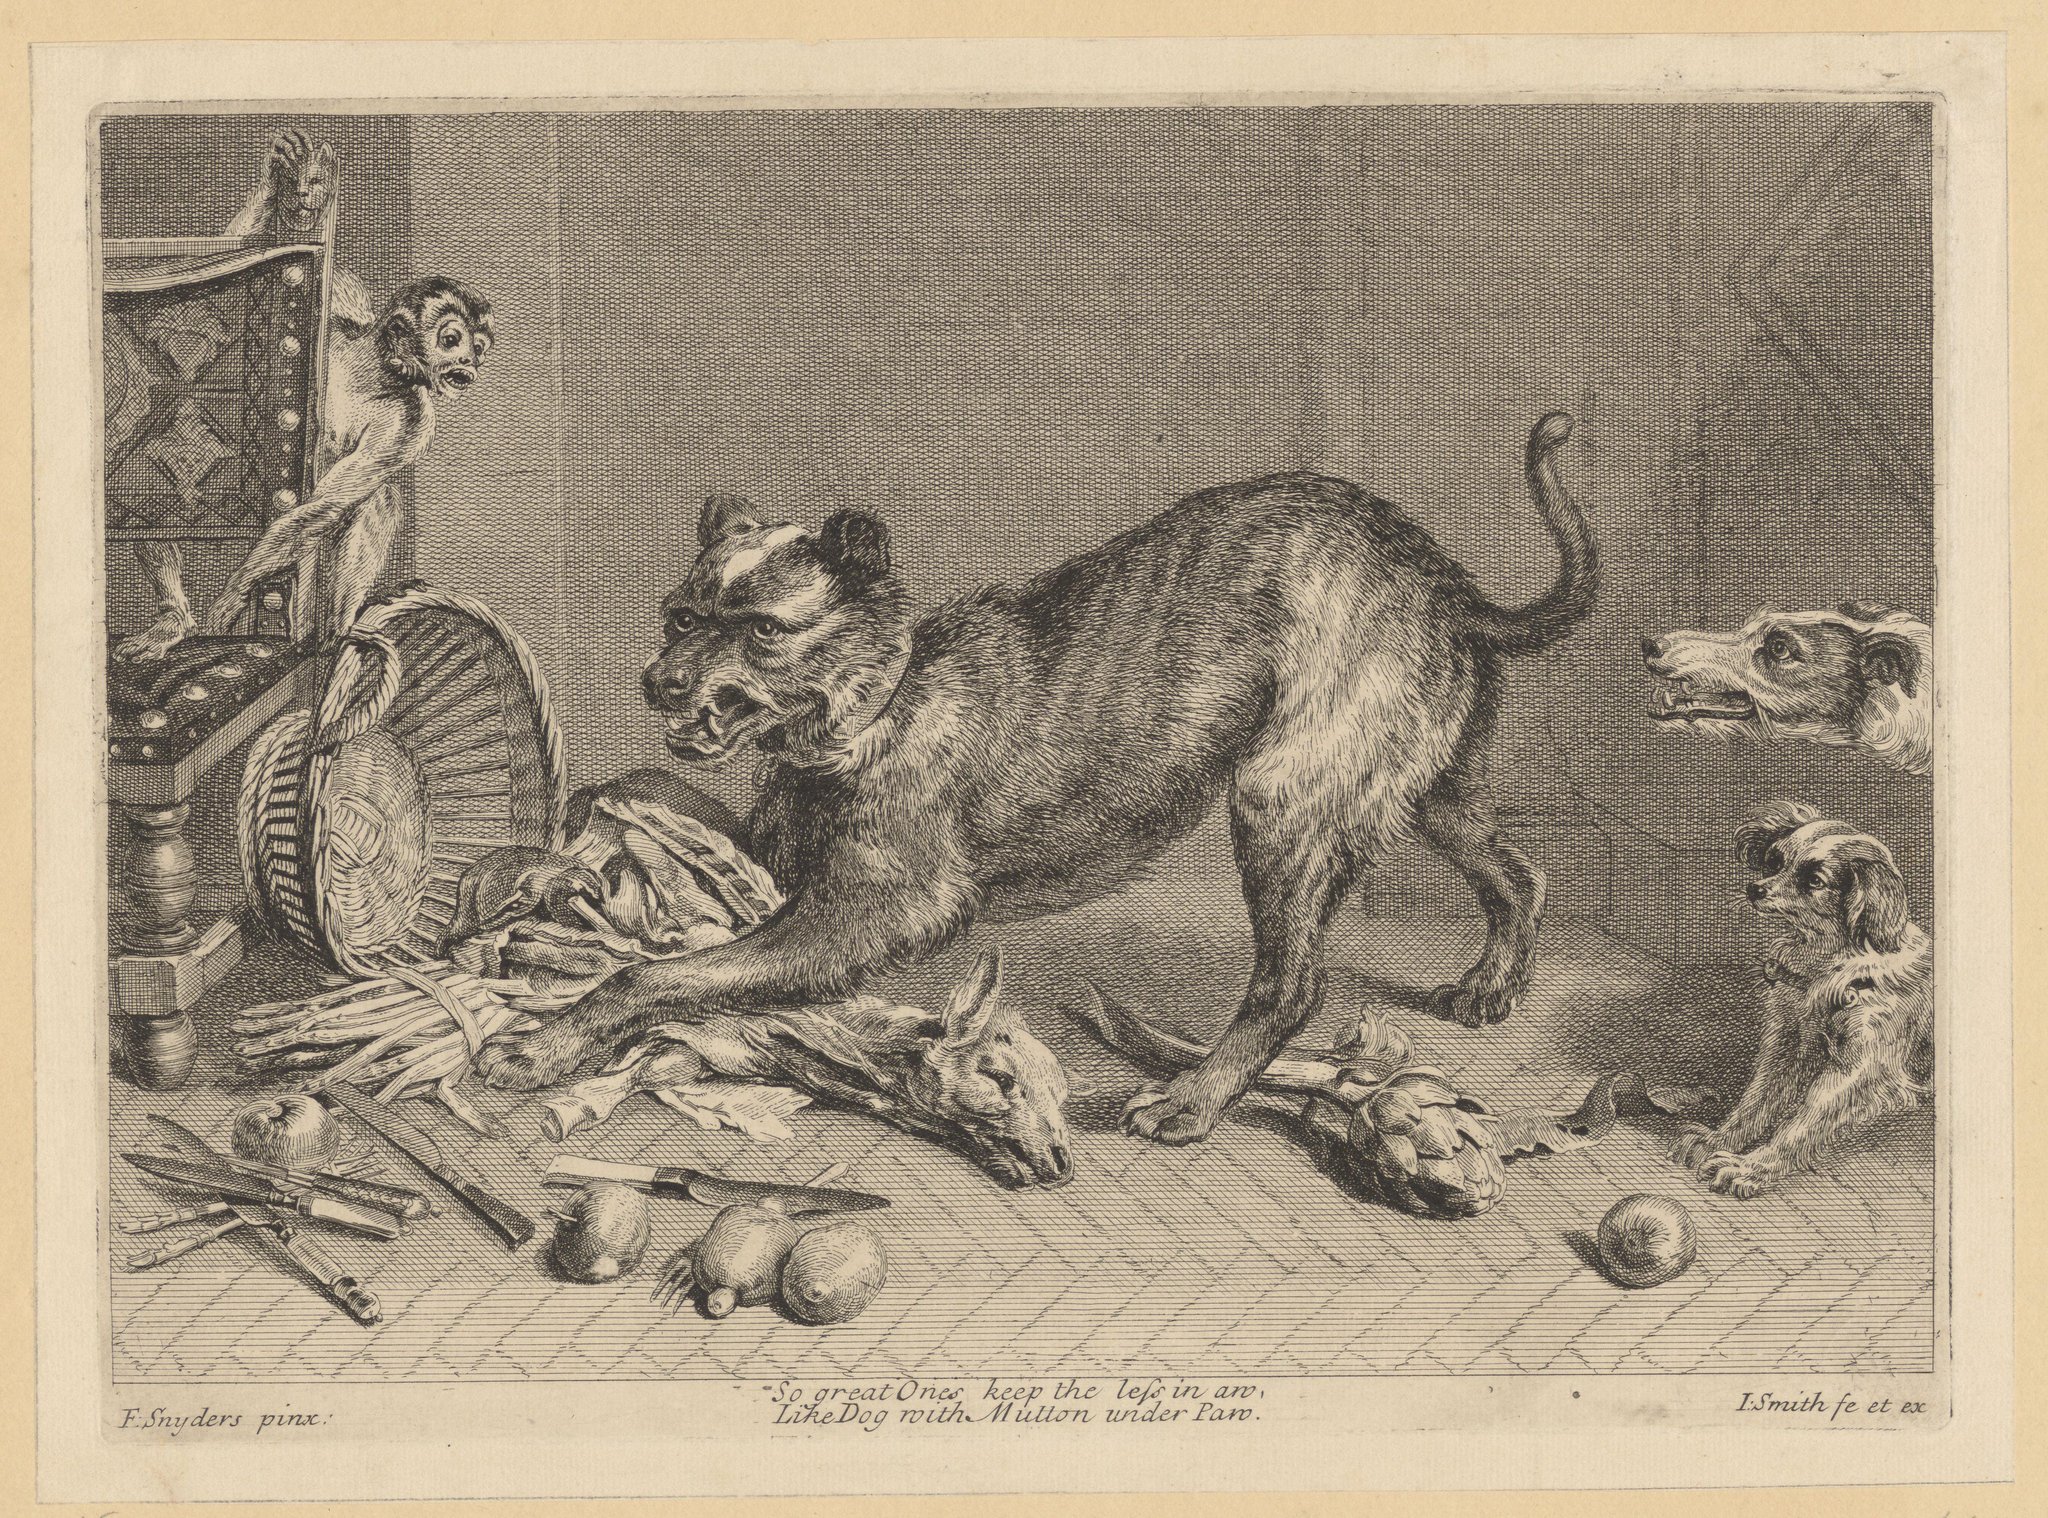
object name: print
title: Hond legt zijn poot op het karkas van een schaap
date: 1662-1743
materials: paper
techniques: etching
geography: london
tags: monkeys, apes, table-knife, sheep, dog, plants and herbs: artichoke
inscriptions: collector's mark: Lugt 240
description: Links hangt een kleine aap aan een stoel. Rechts twee andere honden.